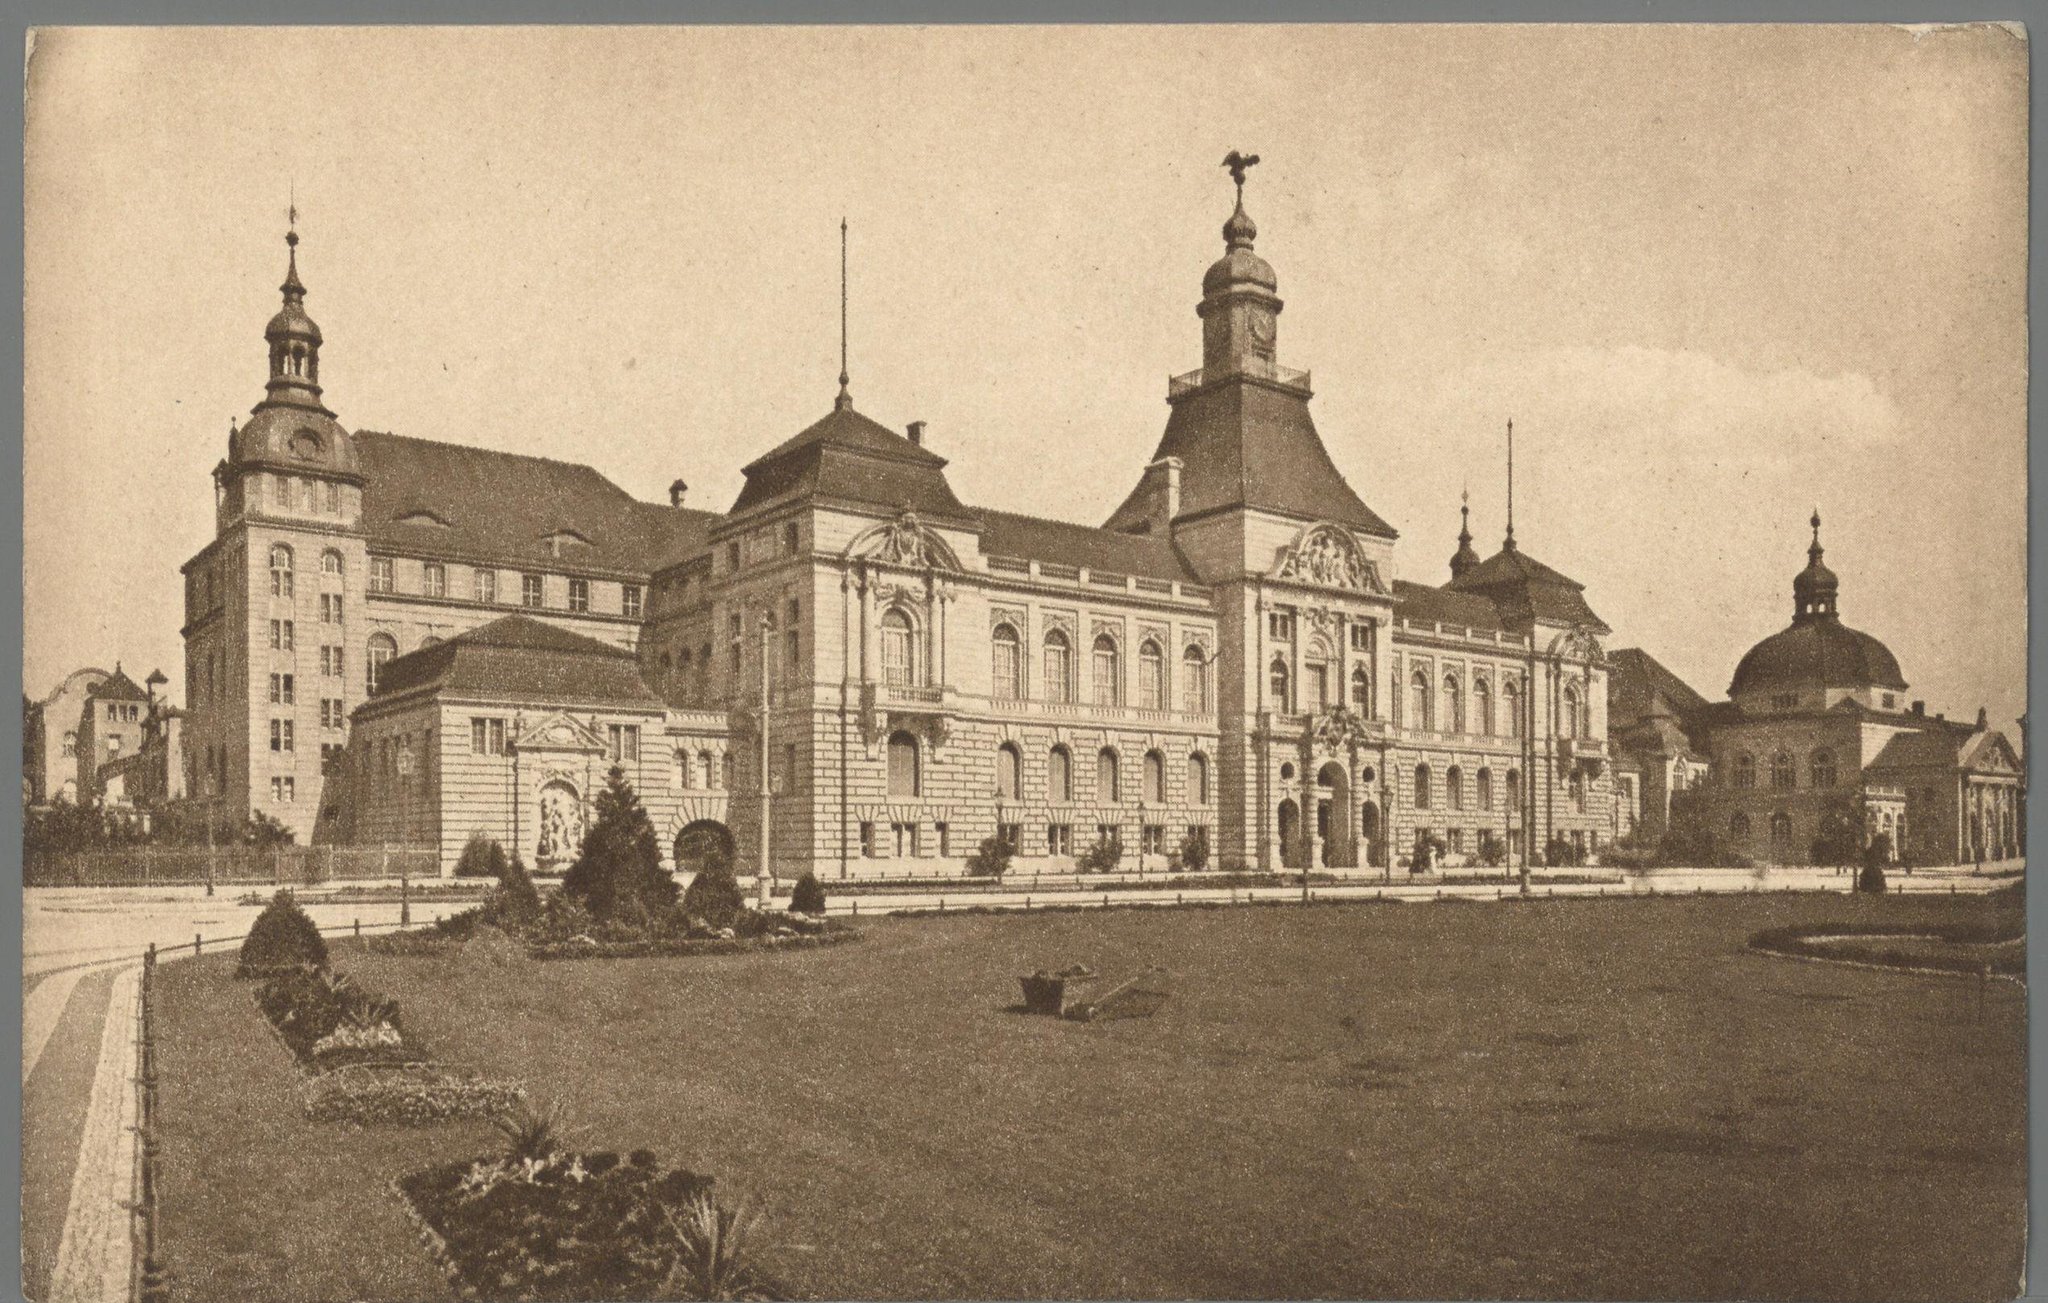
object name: ansichtkaart, prentbriefkaart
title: Charlottenburg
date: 1905-1930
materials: cardboard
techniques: rotogravure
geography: charlottenburg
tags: university building, college